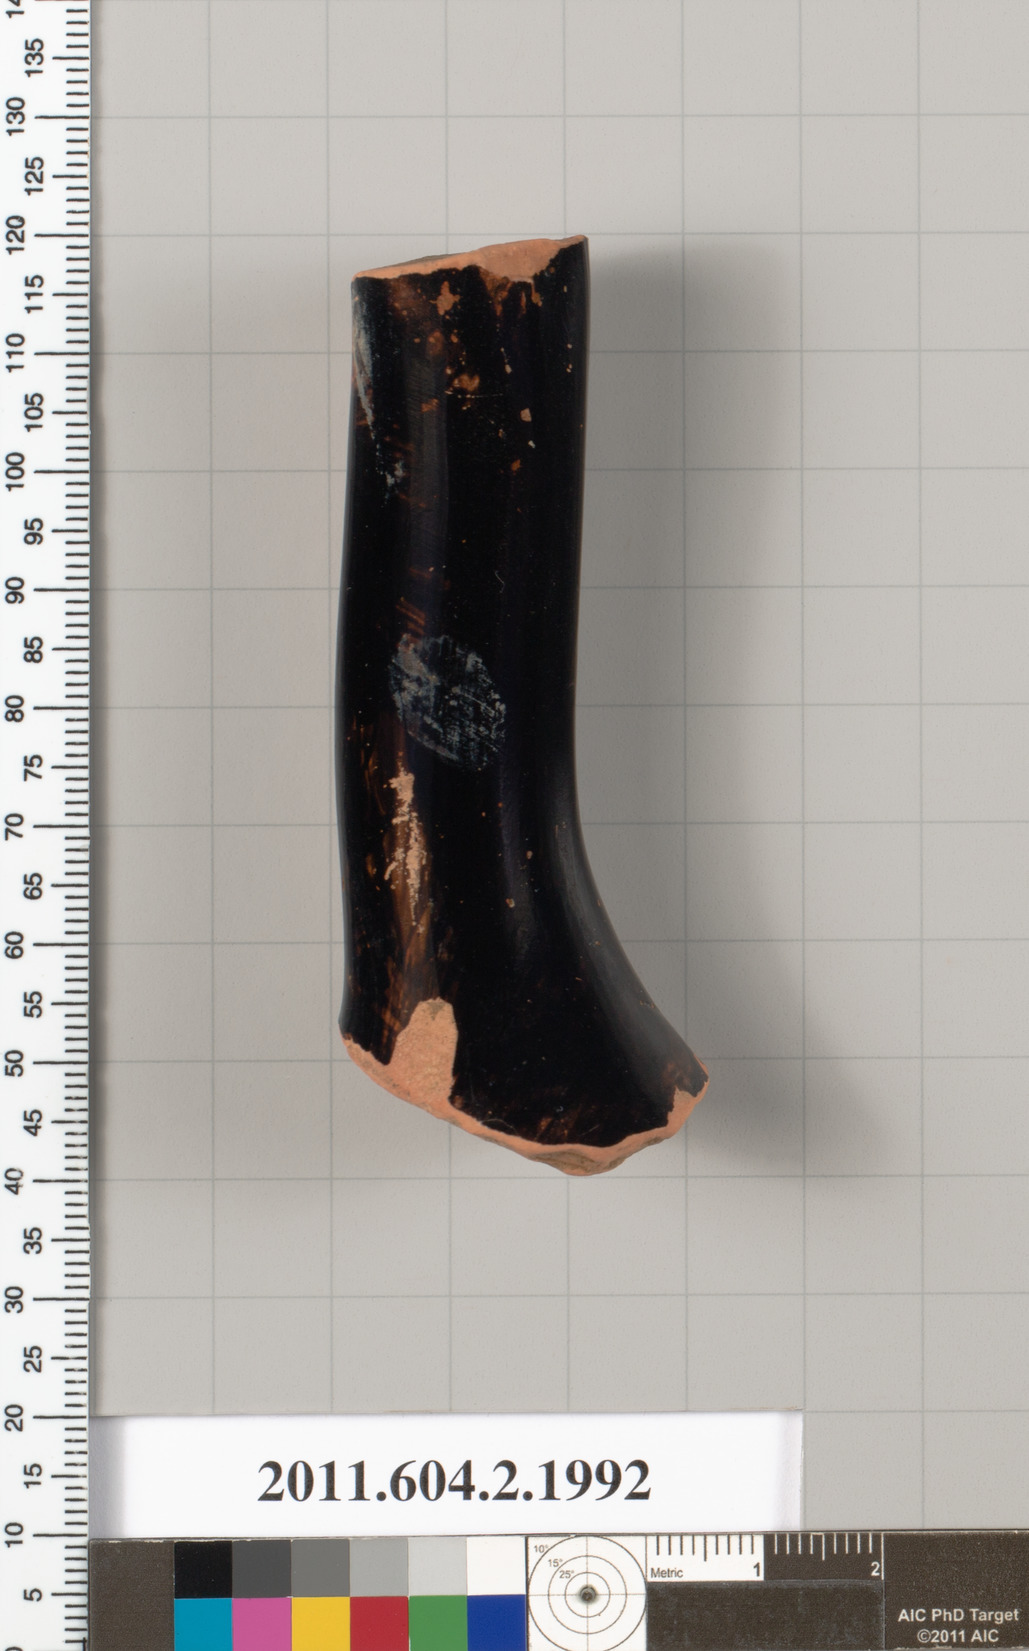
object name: neck amphora fragment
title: Terracotta fragment of a Neck-amphora (jar)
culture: greek, attic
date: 475-451 BCE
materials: terracotta